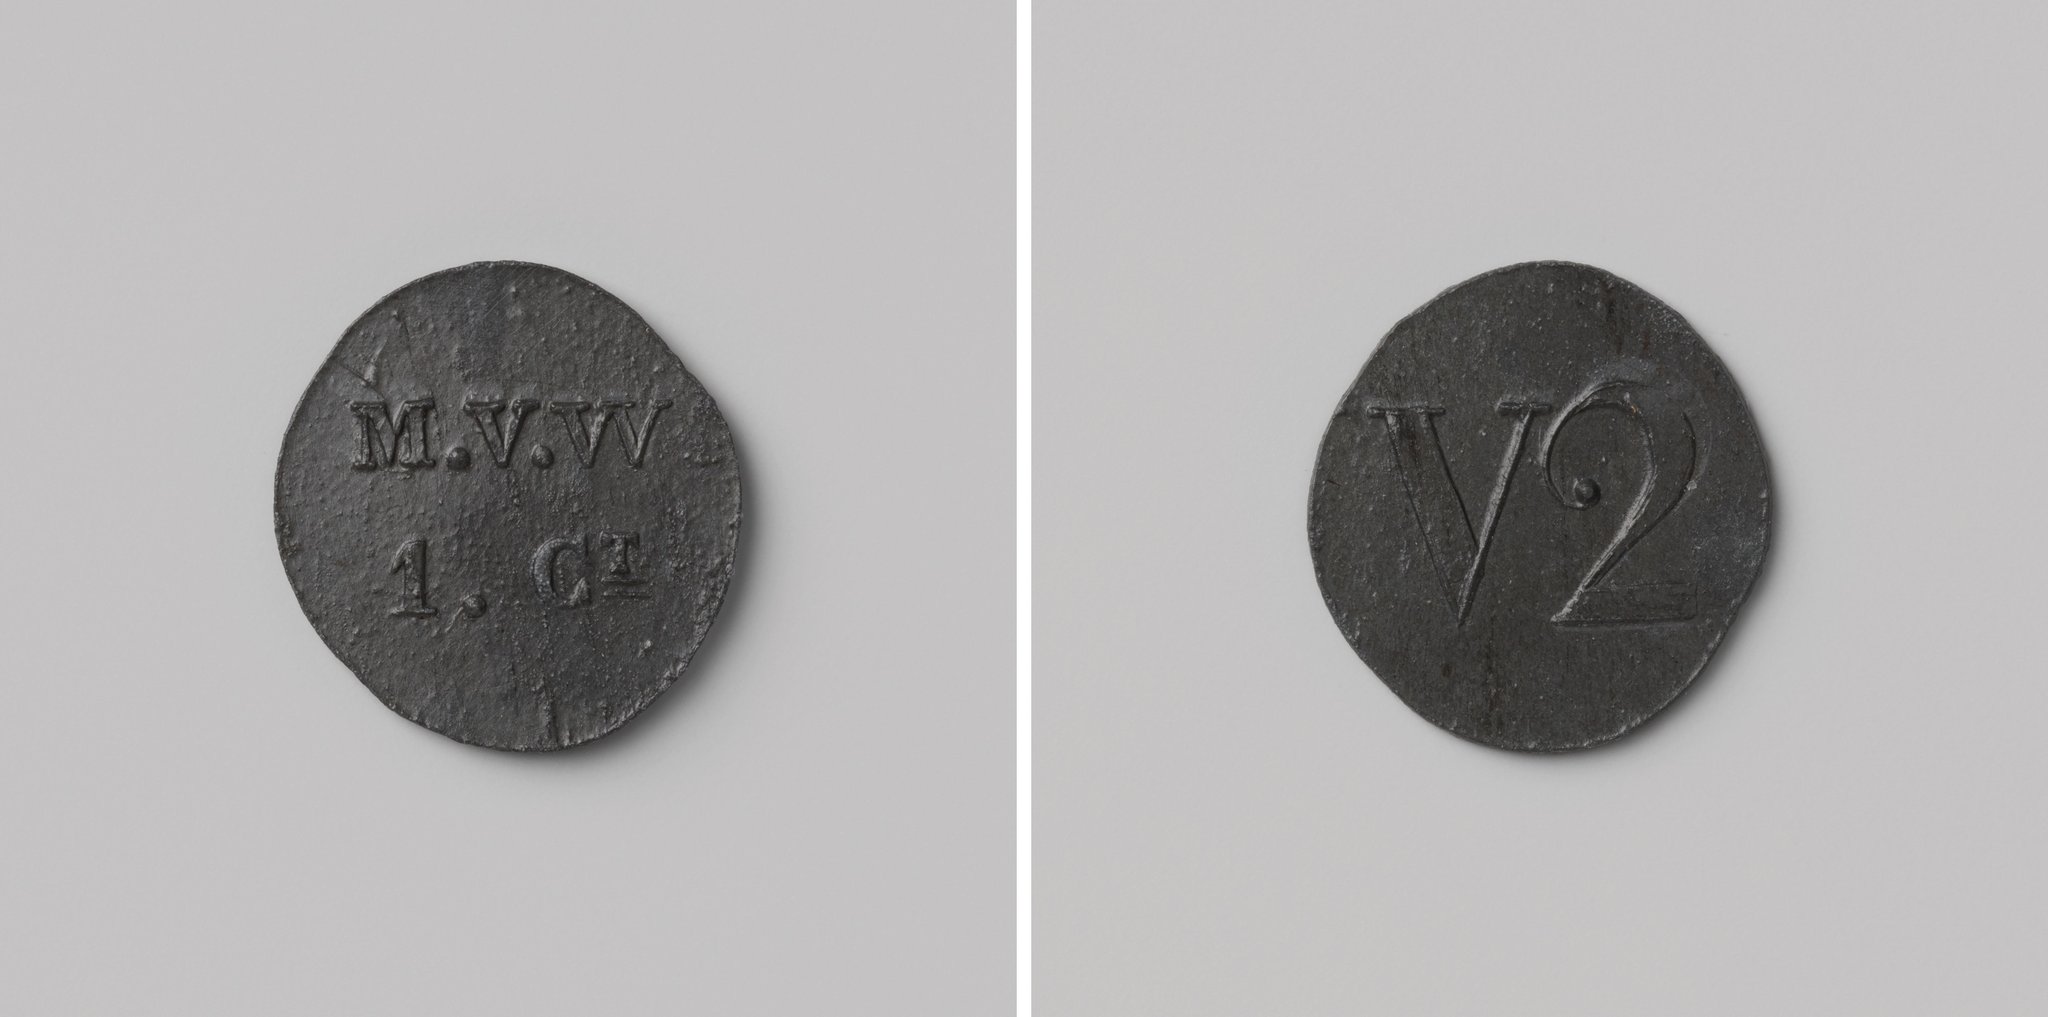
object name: huismunt prison money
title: Tweede gesticht van de strafkolonie Veenhuizen, huismunt geslagen op last van de Maatschappij van Weldadigheid ter waarde van 1 cent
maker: Anonymous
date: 1818-1859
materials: zinc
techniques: striking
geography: netherlands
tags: maatschappij van weldadigheid, veenhuizen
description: Zinken munt. Voorzijde: opschrift boven waardeaanduiding. Keerzijde: opschrift V en 2